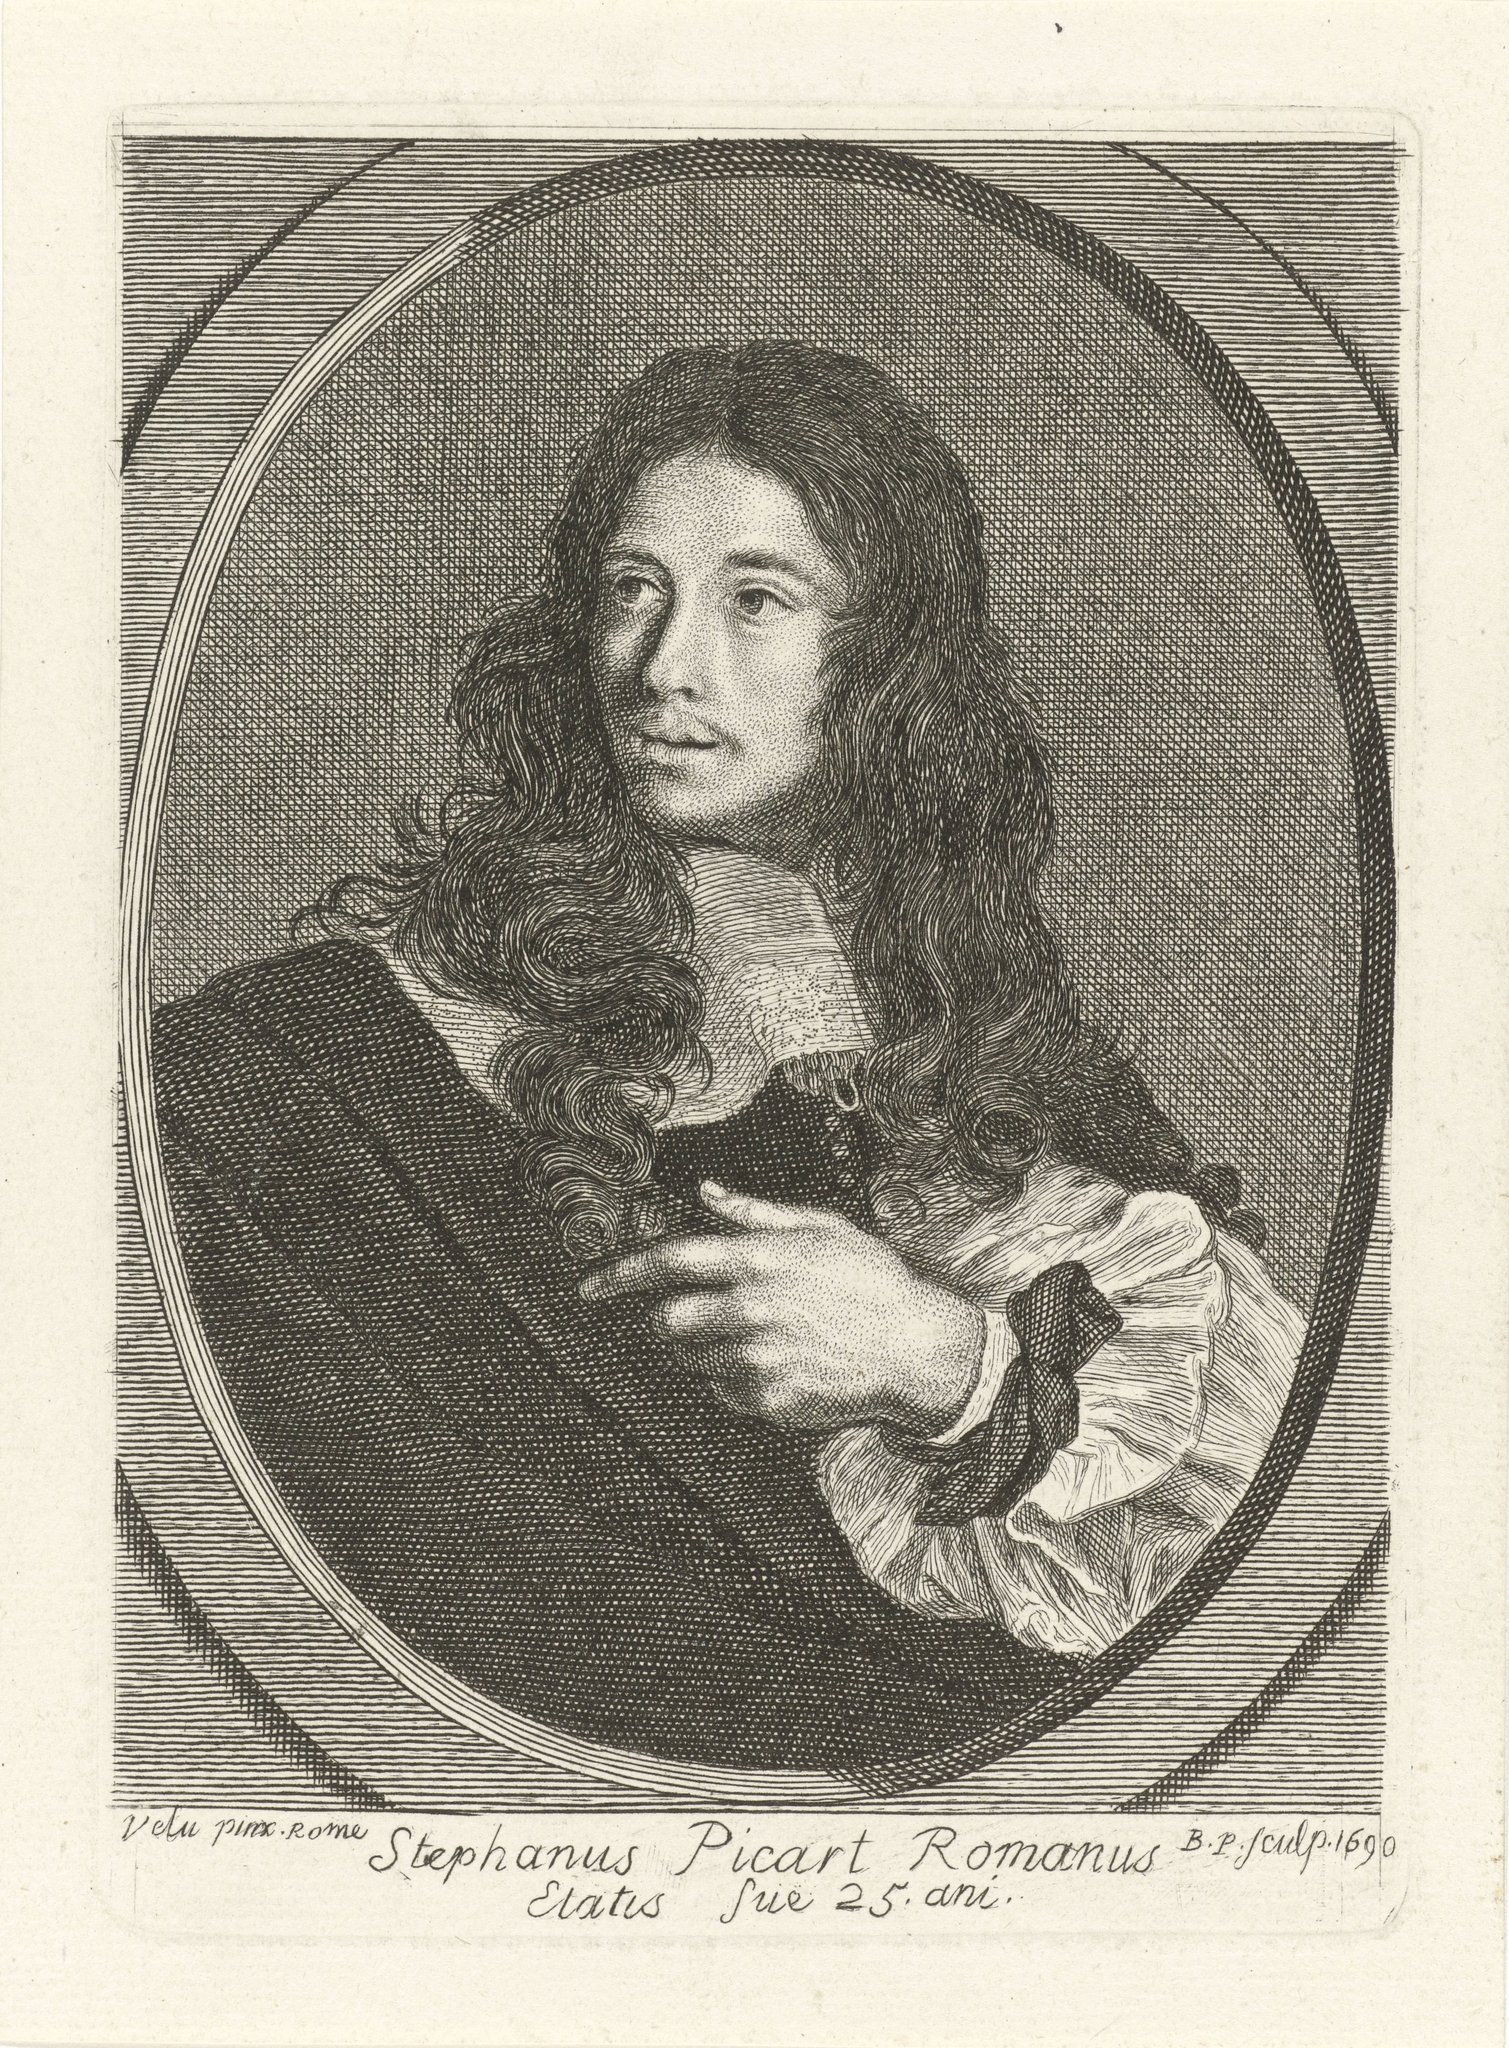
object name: print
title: Portret van Etienne Picart op 25-jarige leeftijd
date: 1690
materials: paper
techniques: engraving, etching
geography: rome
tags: paris, print maker, draughtsman, etienne picart, historical persons, portrait, self-portrait of graphic artist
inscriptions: collector's mark: Lugt 2228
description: Portret van Etienne (Stephanus) Picart, ook wel 'de Romein' genoemd, op 25-jarige leeftijd. Hij is de vader van de kunstenaar.